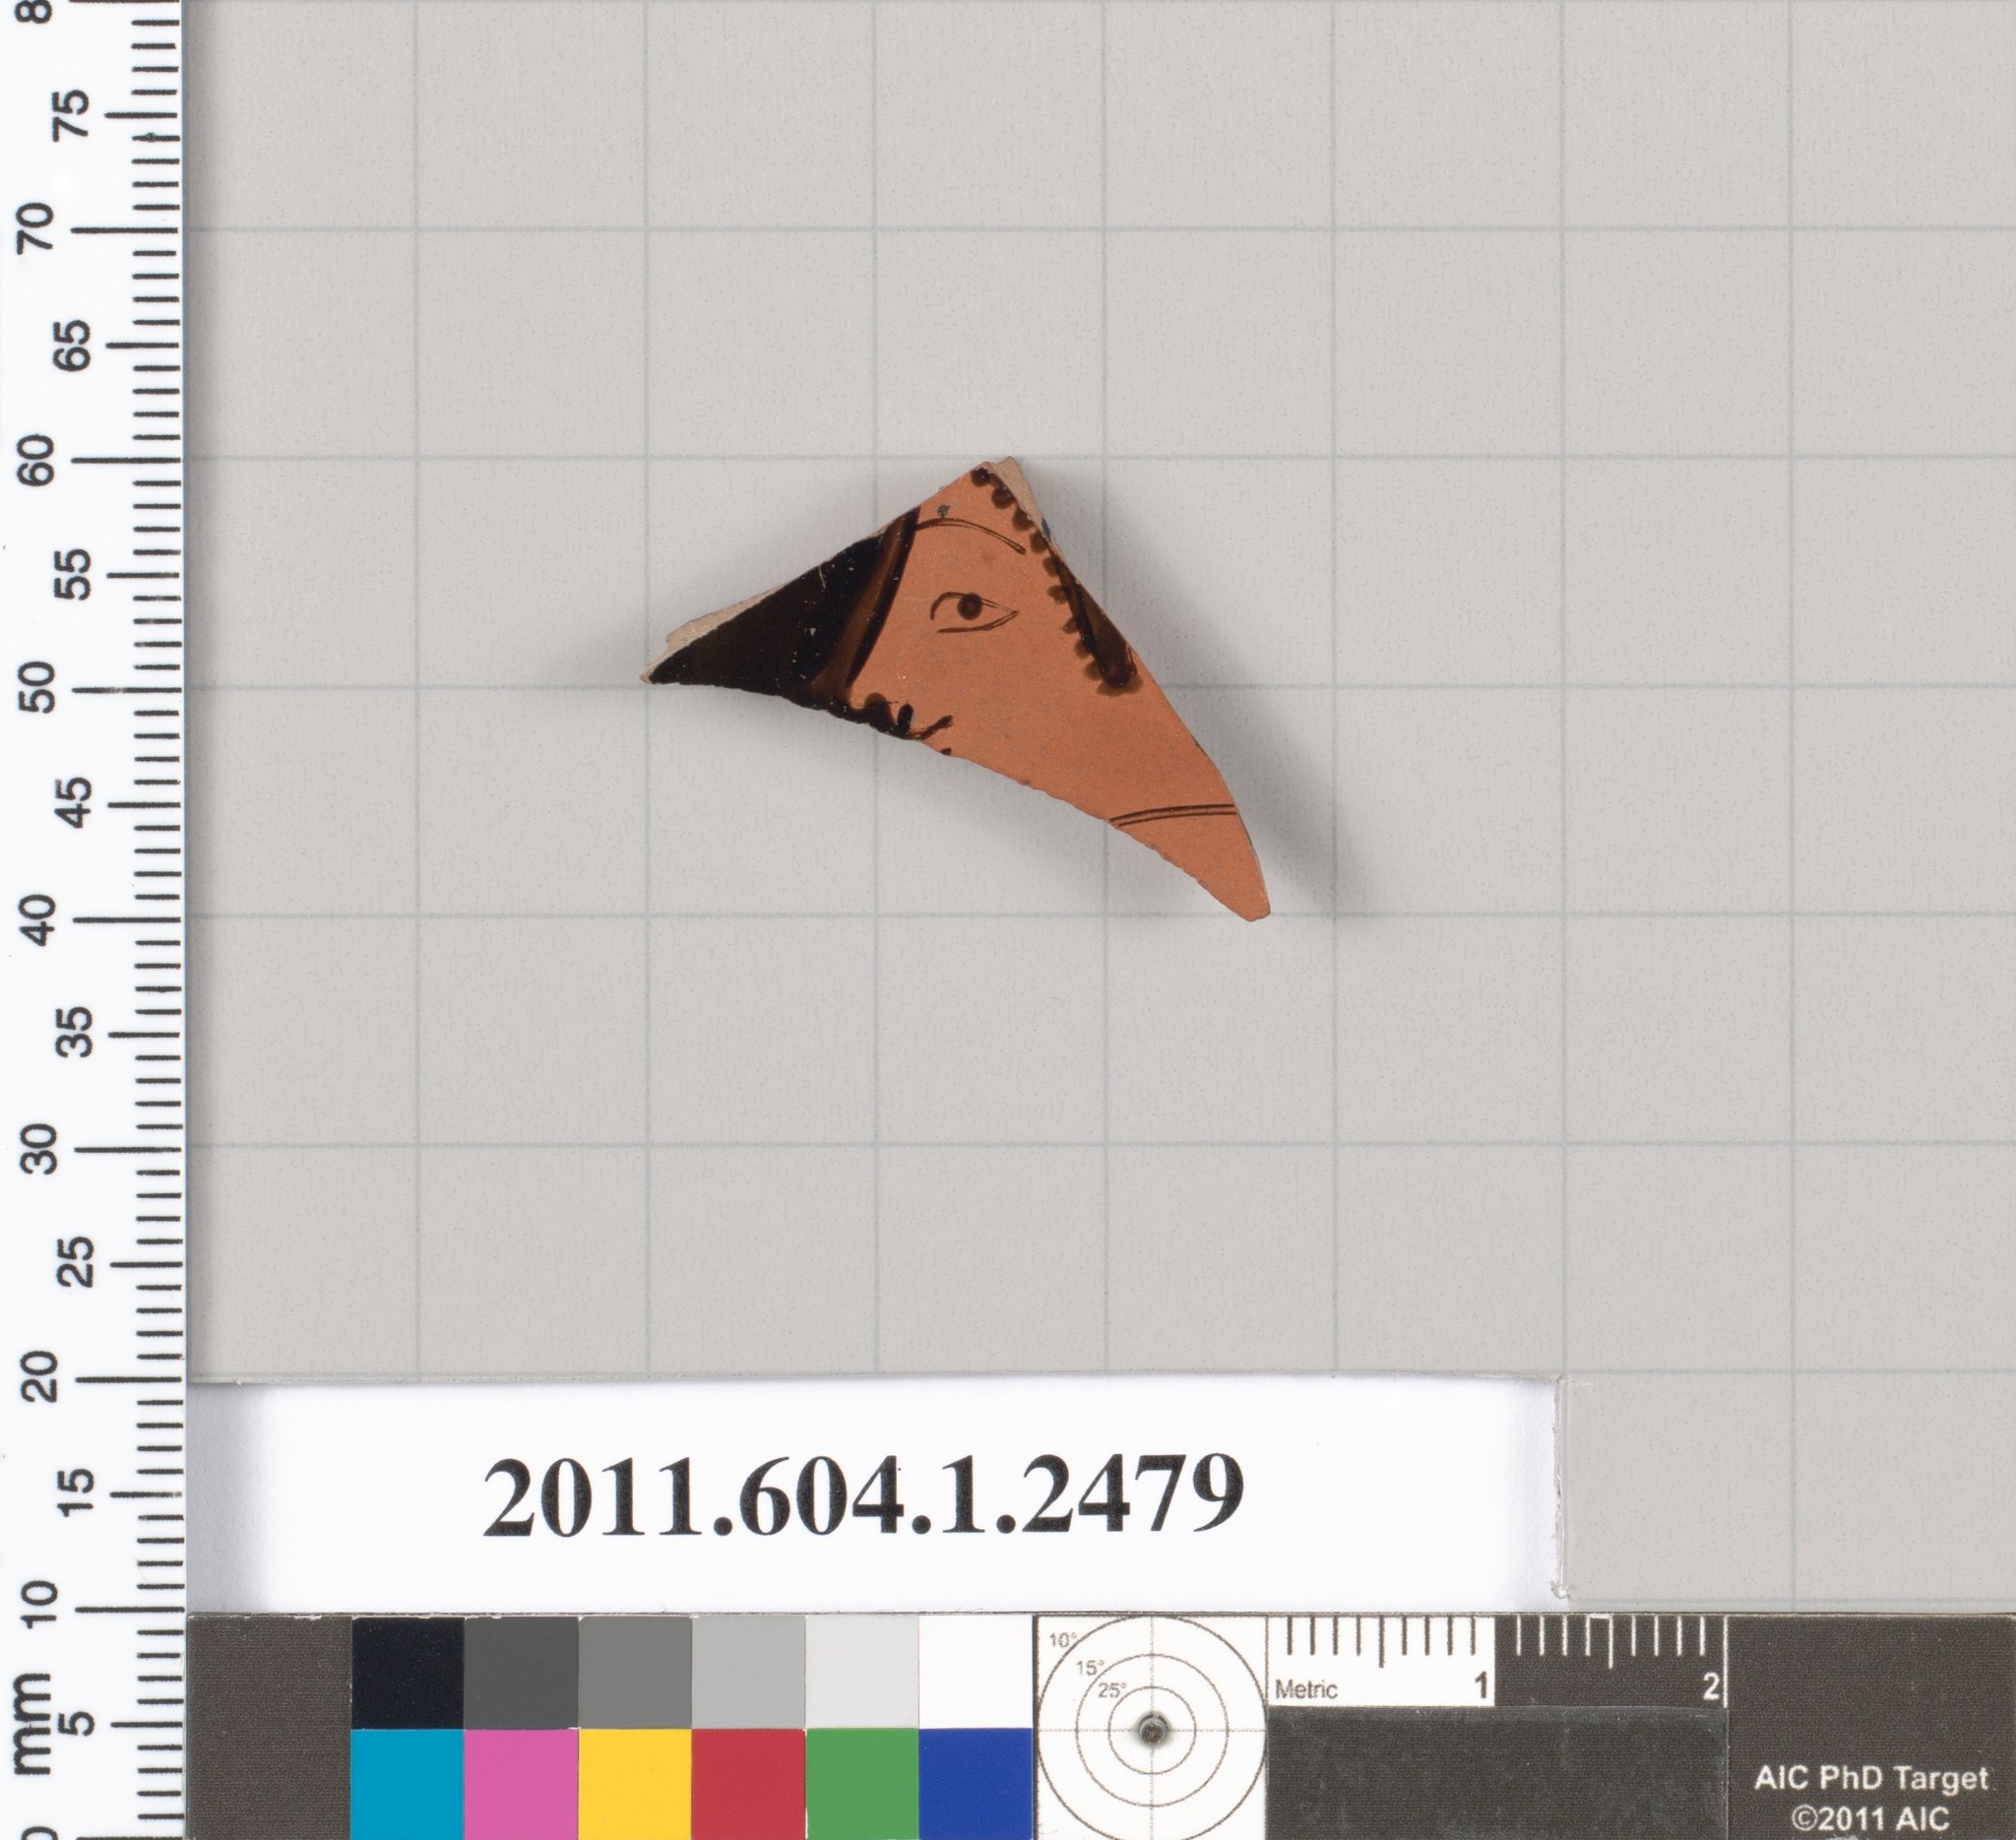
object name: kylix fragment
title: Terracotta fragment of a kylix (drinking cup)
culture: greek, attic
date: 520-500 BCE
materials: terracotta